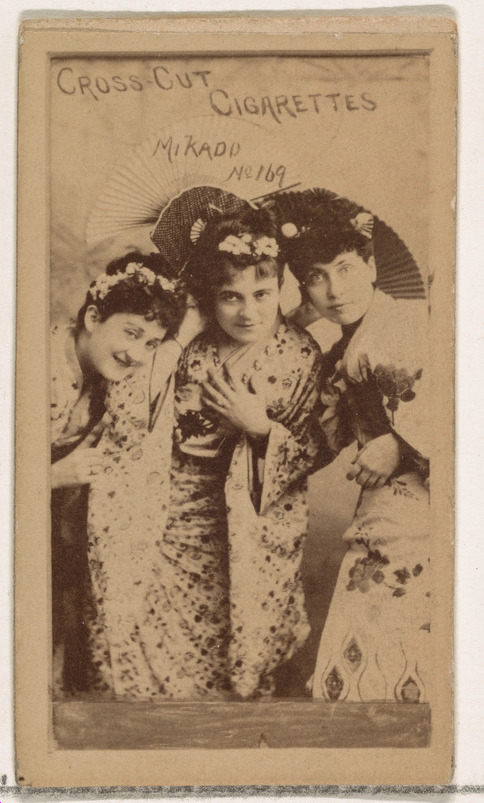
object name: print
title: Card Number 169, Mikado, from the Actors and Actresses series (N145-1) issued by Duke Sons & Co. to promote Cross Cut Cigarettes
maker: w. duke, sons & co.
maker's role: publisher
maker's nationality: american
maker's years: 1870-1920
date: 1880-1889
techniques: albumen silver print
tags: portraits,women,actresses